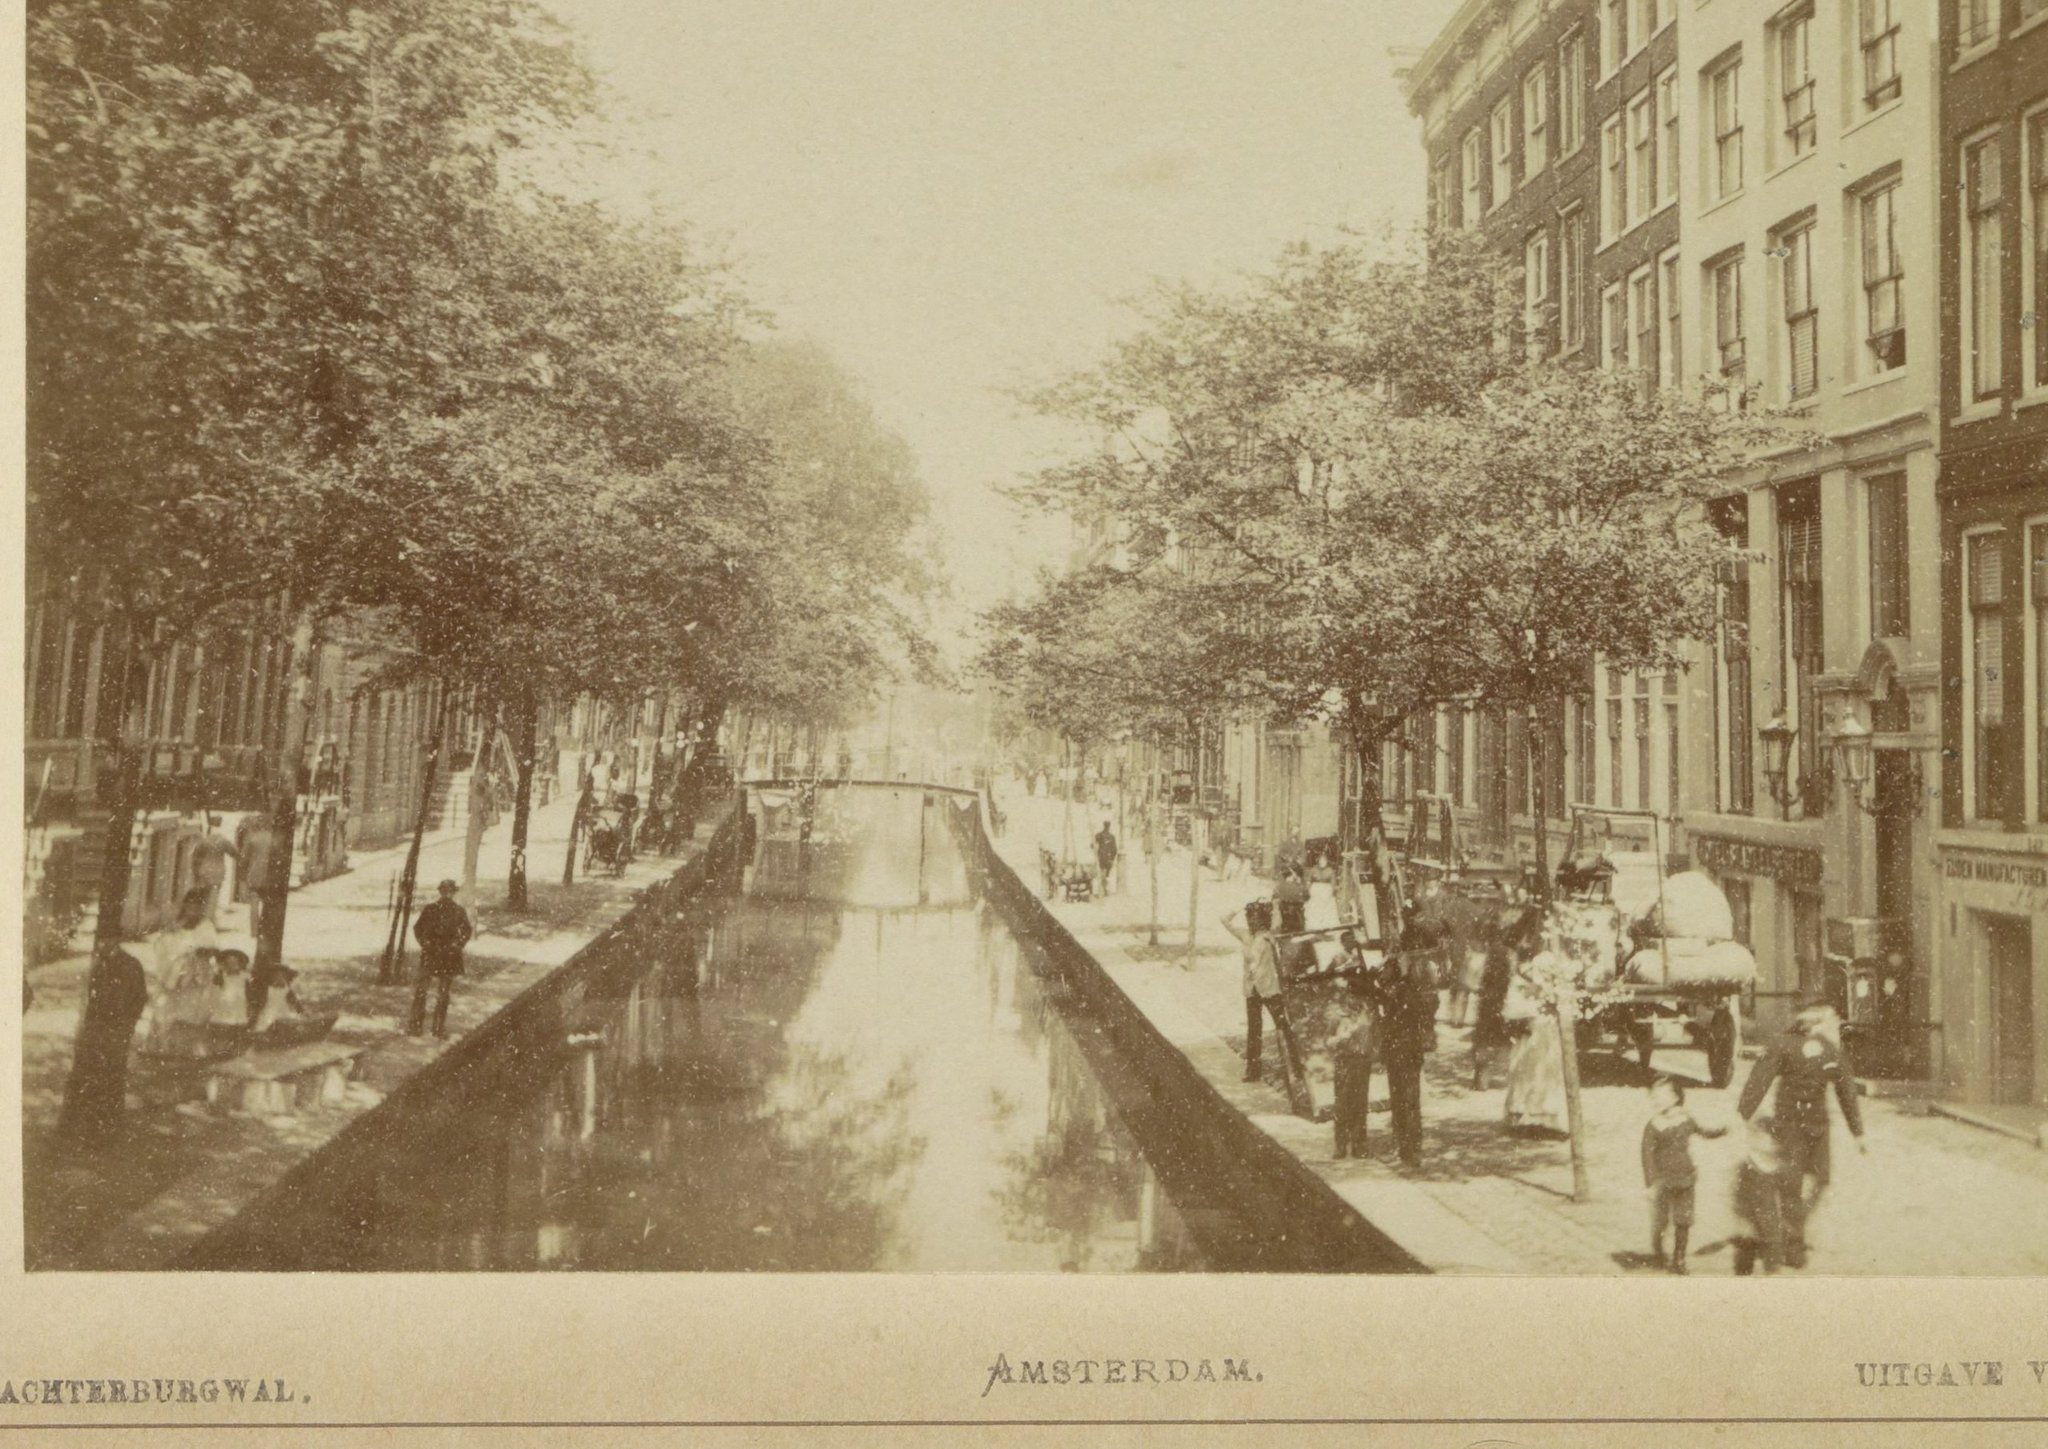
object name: photograph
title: Gezicht op de Oudezijds Achterburgwal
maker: andries jager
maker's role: publisher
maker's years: 1825-1905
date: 1860-1907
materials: cardboard, photographic support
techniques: albumen print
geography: amsterdam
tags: canal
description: Onderdeel van Leporelloalbum met 24 foto's van Amsterdam.